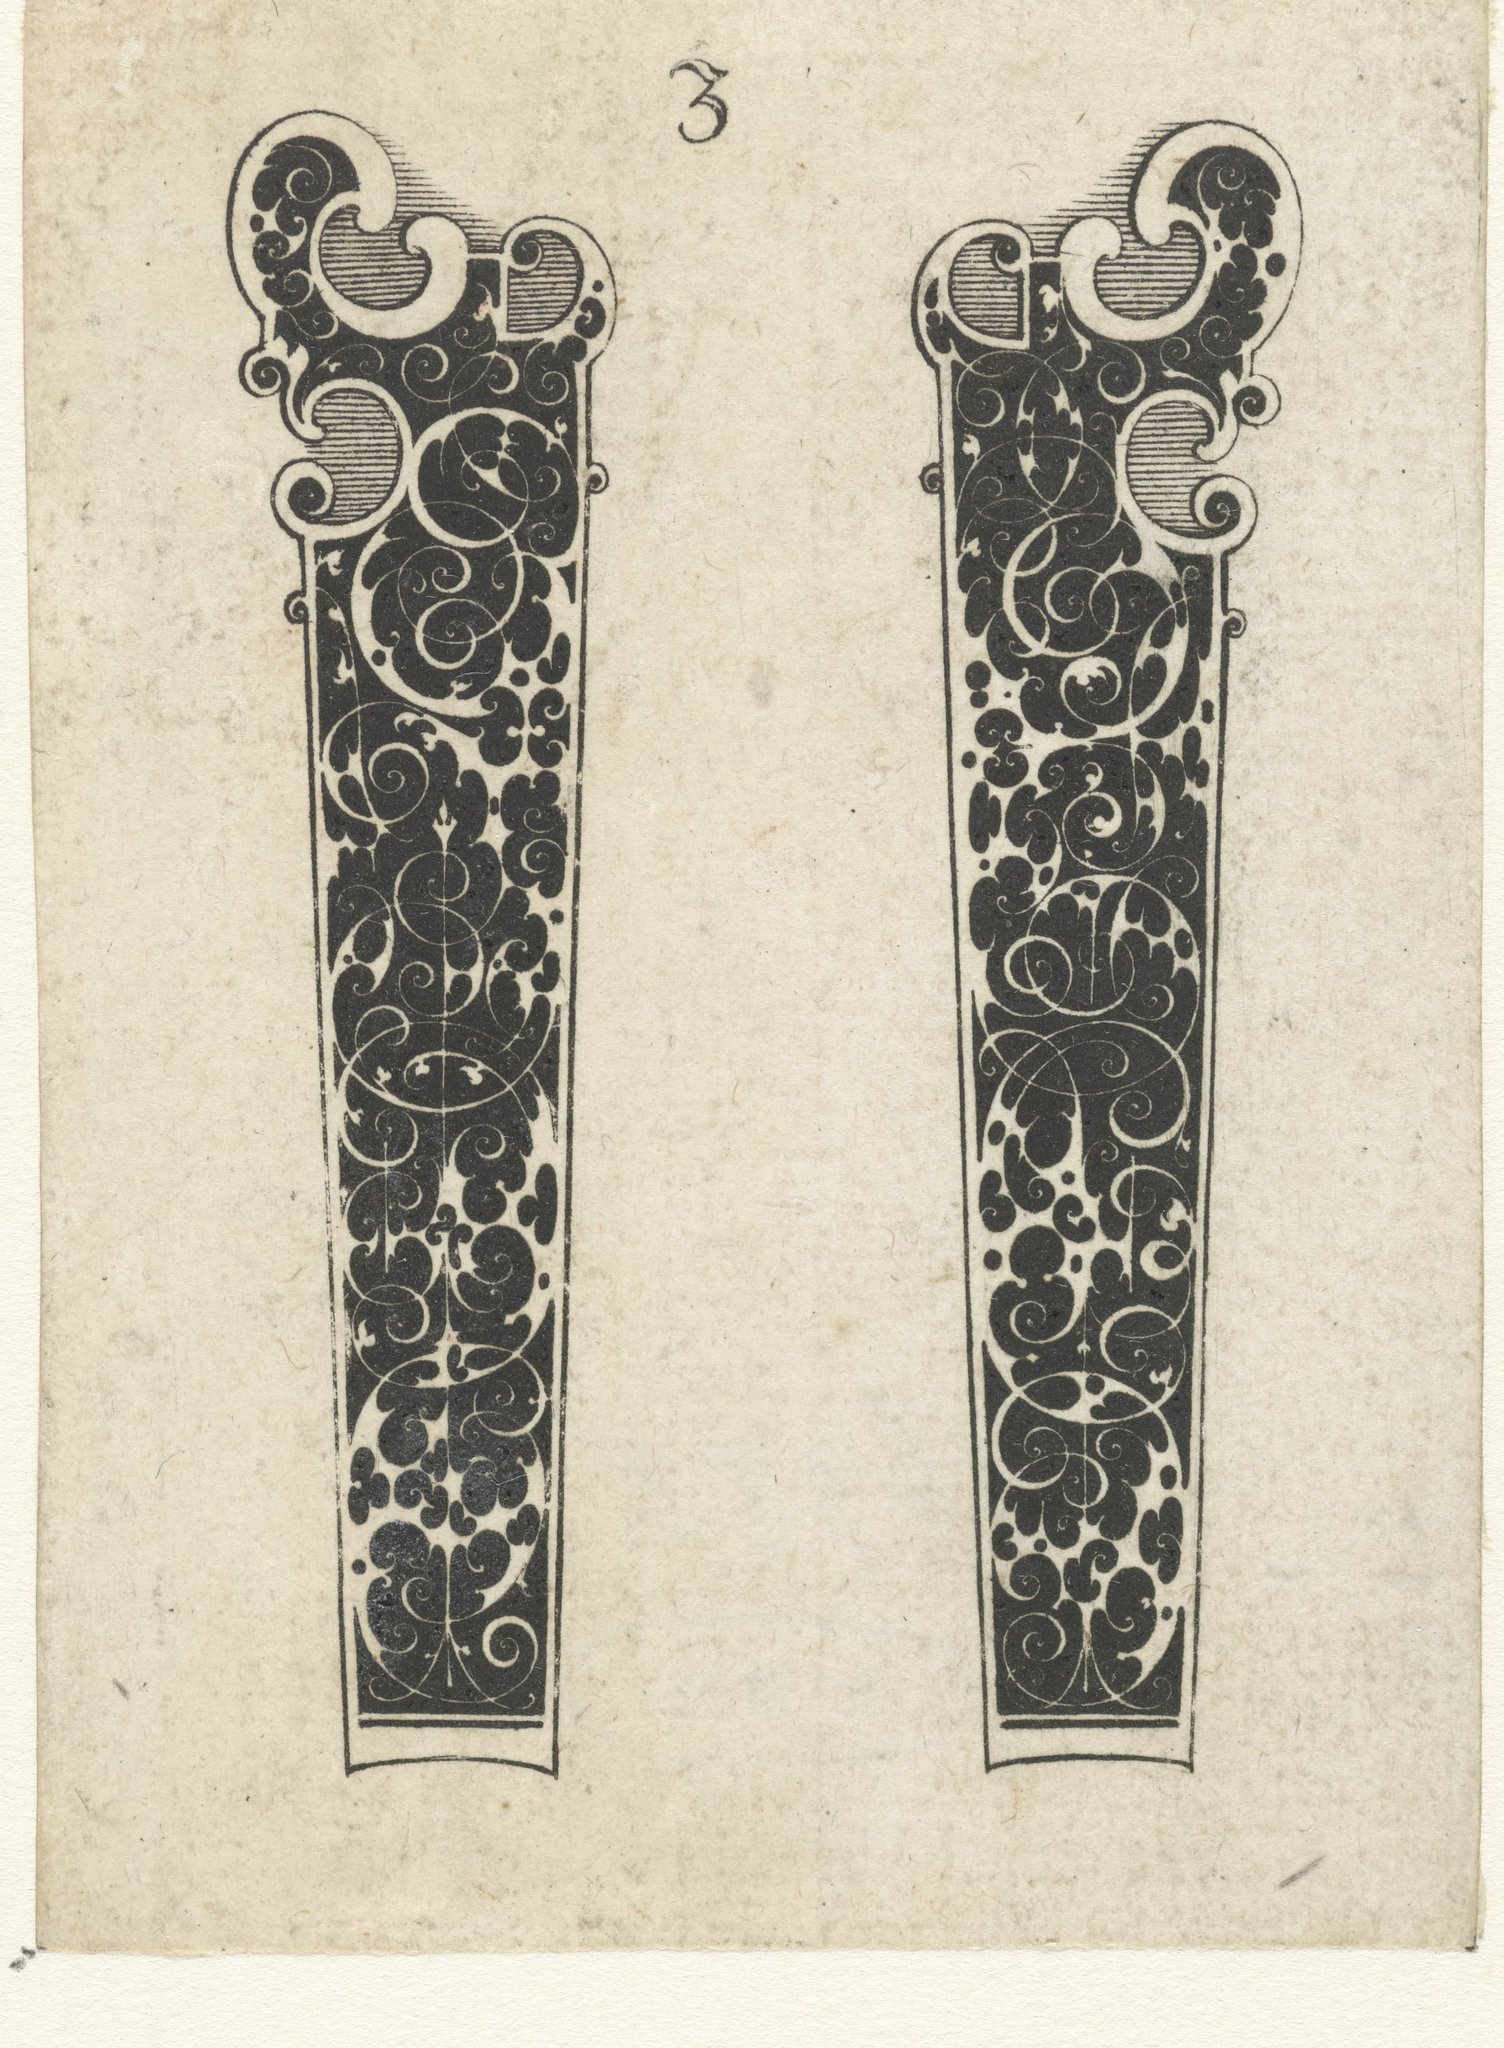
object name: ornament print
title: Twee messenheften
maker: michiel le blon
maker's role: print maker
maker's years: 1587-1656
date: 1597-1625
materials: paper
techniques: etching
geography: amsterdam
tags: table-knife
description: Op elk blad uit deze serie staan twee messenheften naast elkaar afgebeeld, gedecoreerd met Schweifwerk en gestileerde ranken in wit op een zwarte ondergrond.